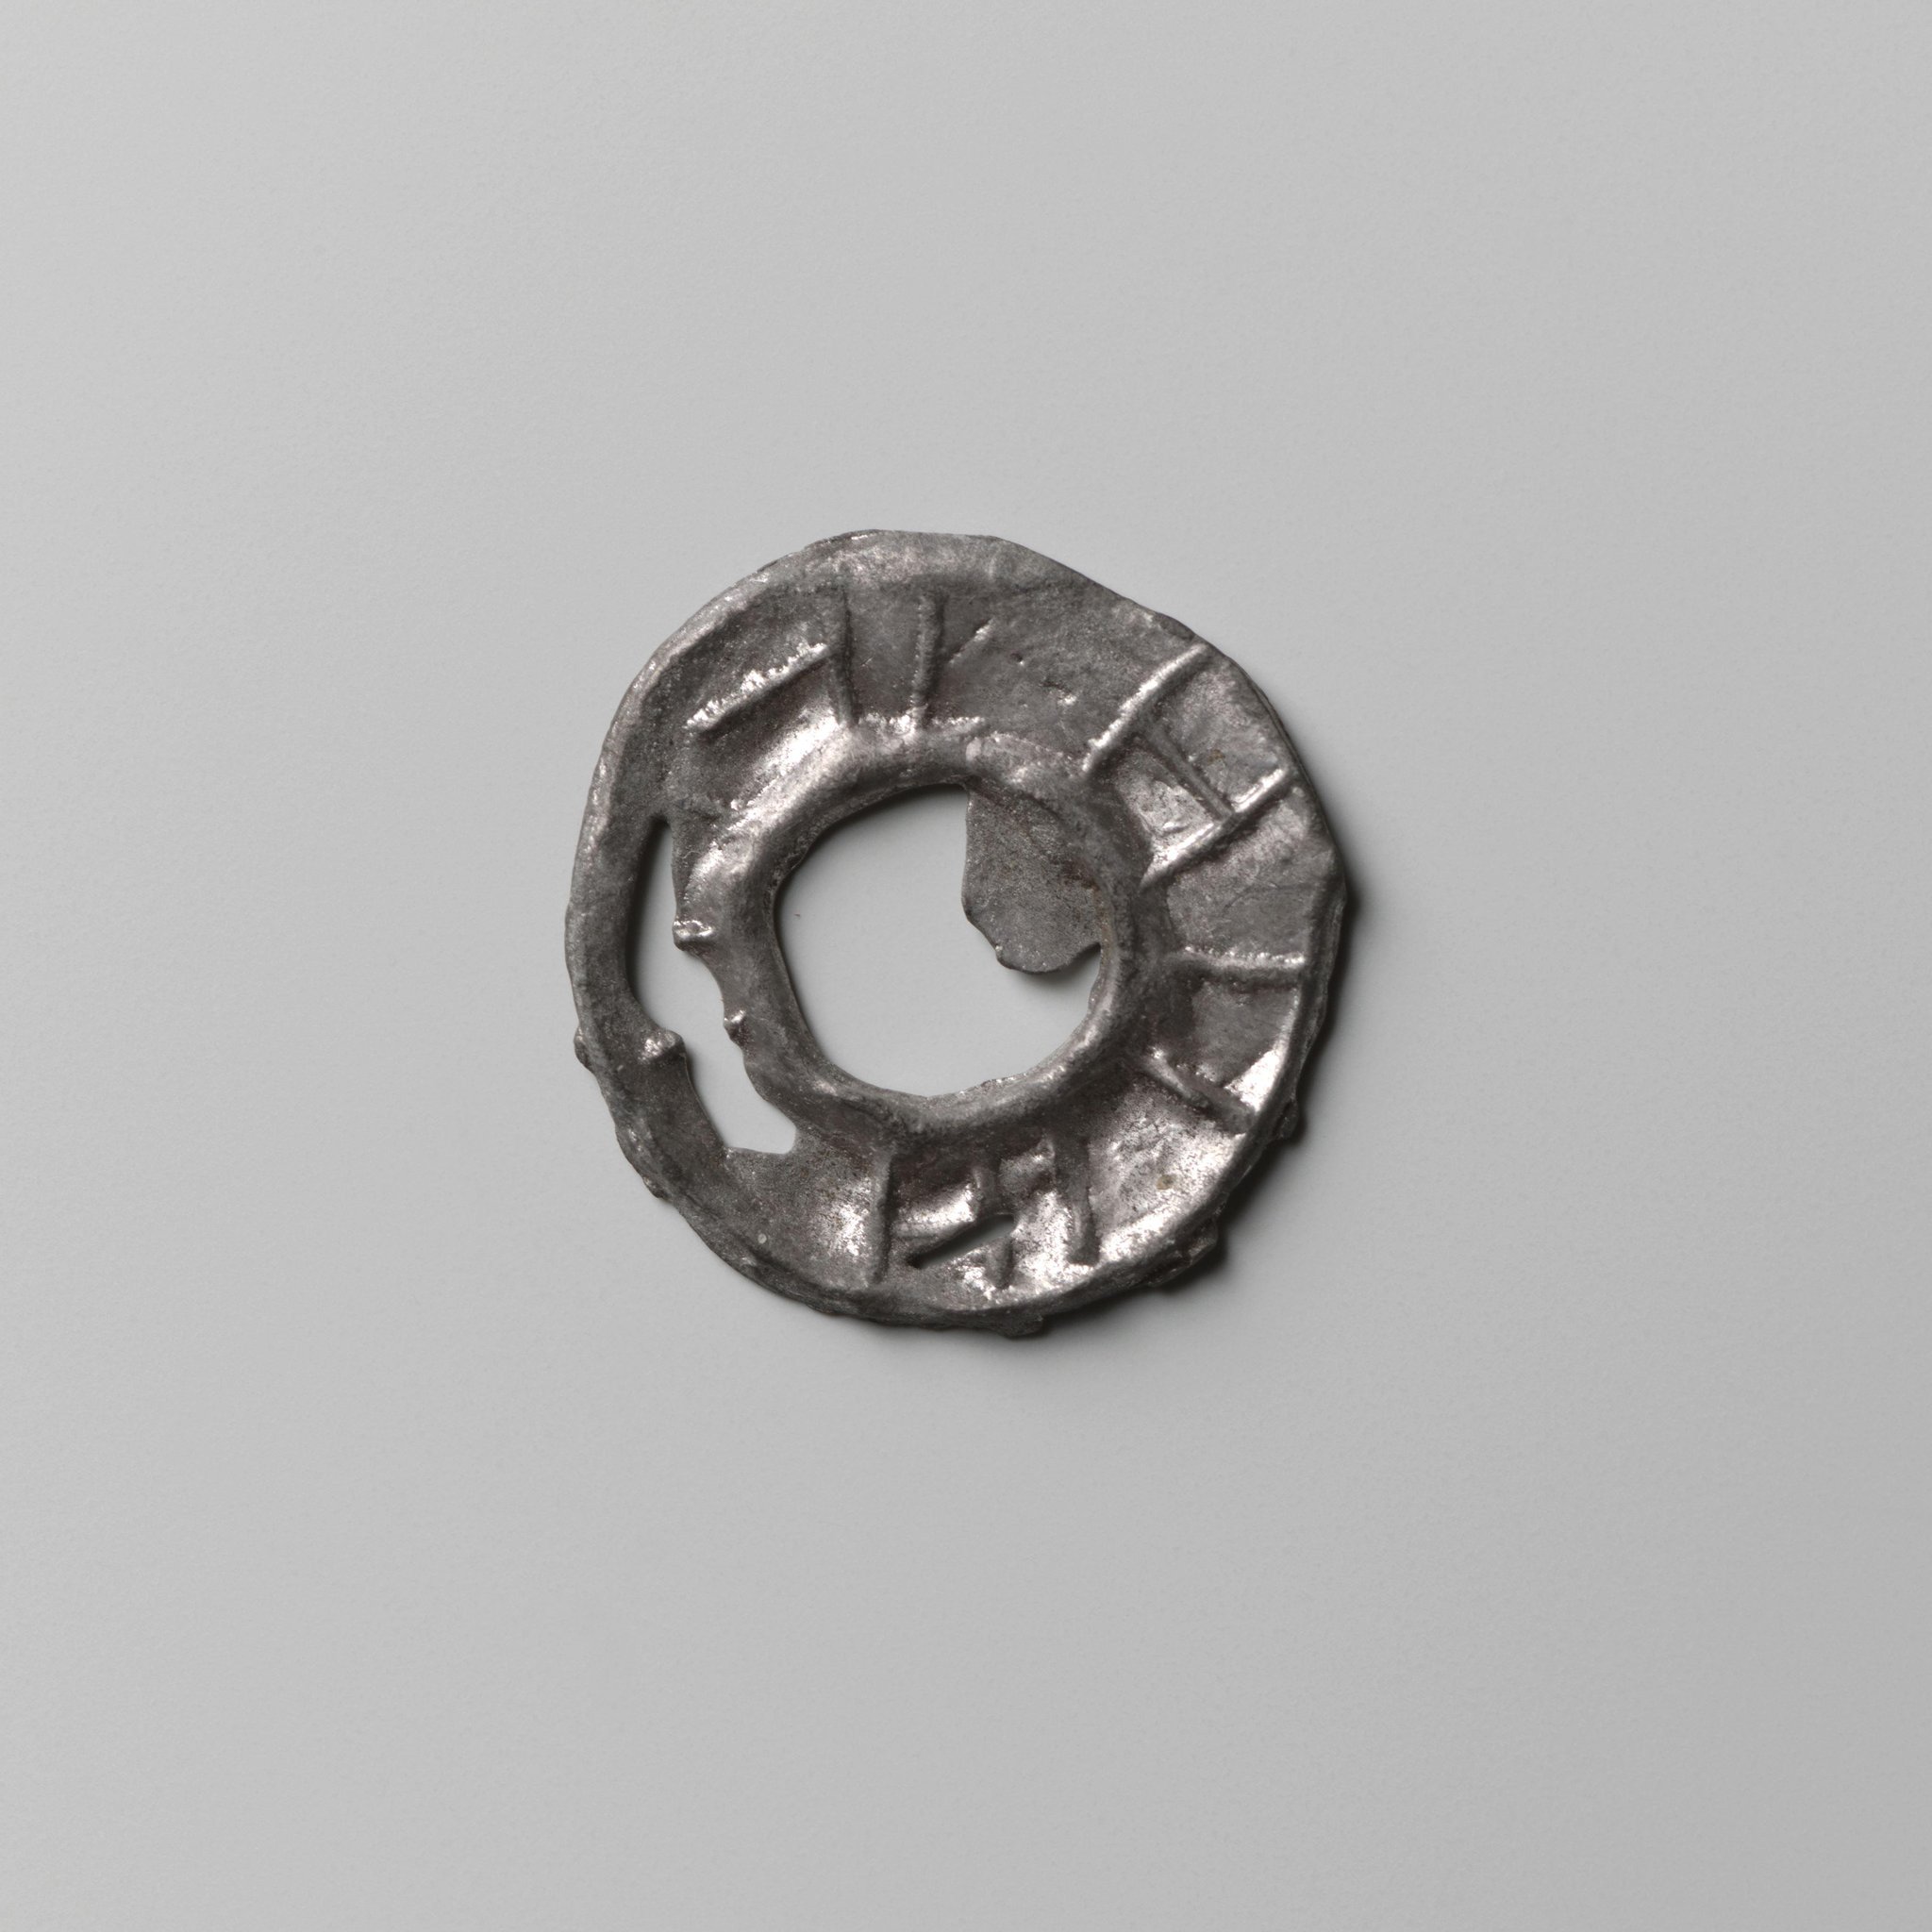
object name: coin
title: Djambi, Sumatra, pitji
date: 1700-1850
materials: tin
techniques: casting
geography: djambi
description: Tinnen munt. Voorzijde: omschrift in Javaanse (?) lettertekens. Keerzijde: glad. In het midden op uitstulping na rond gat.